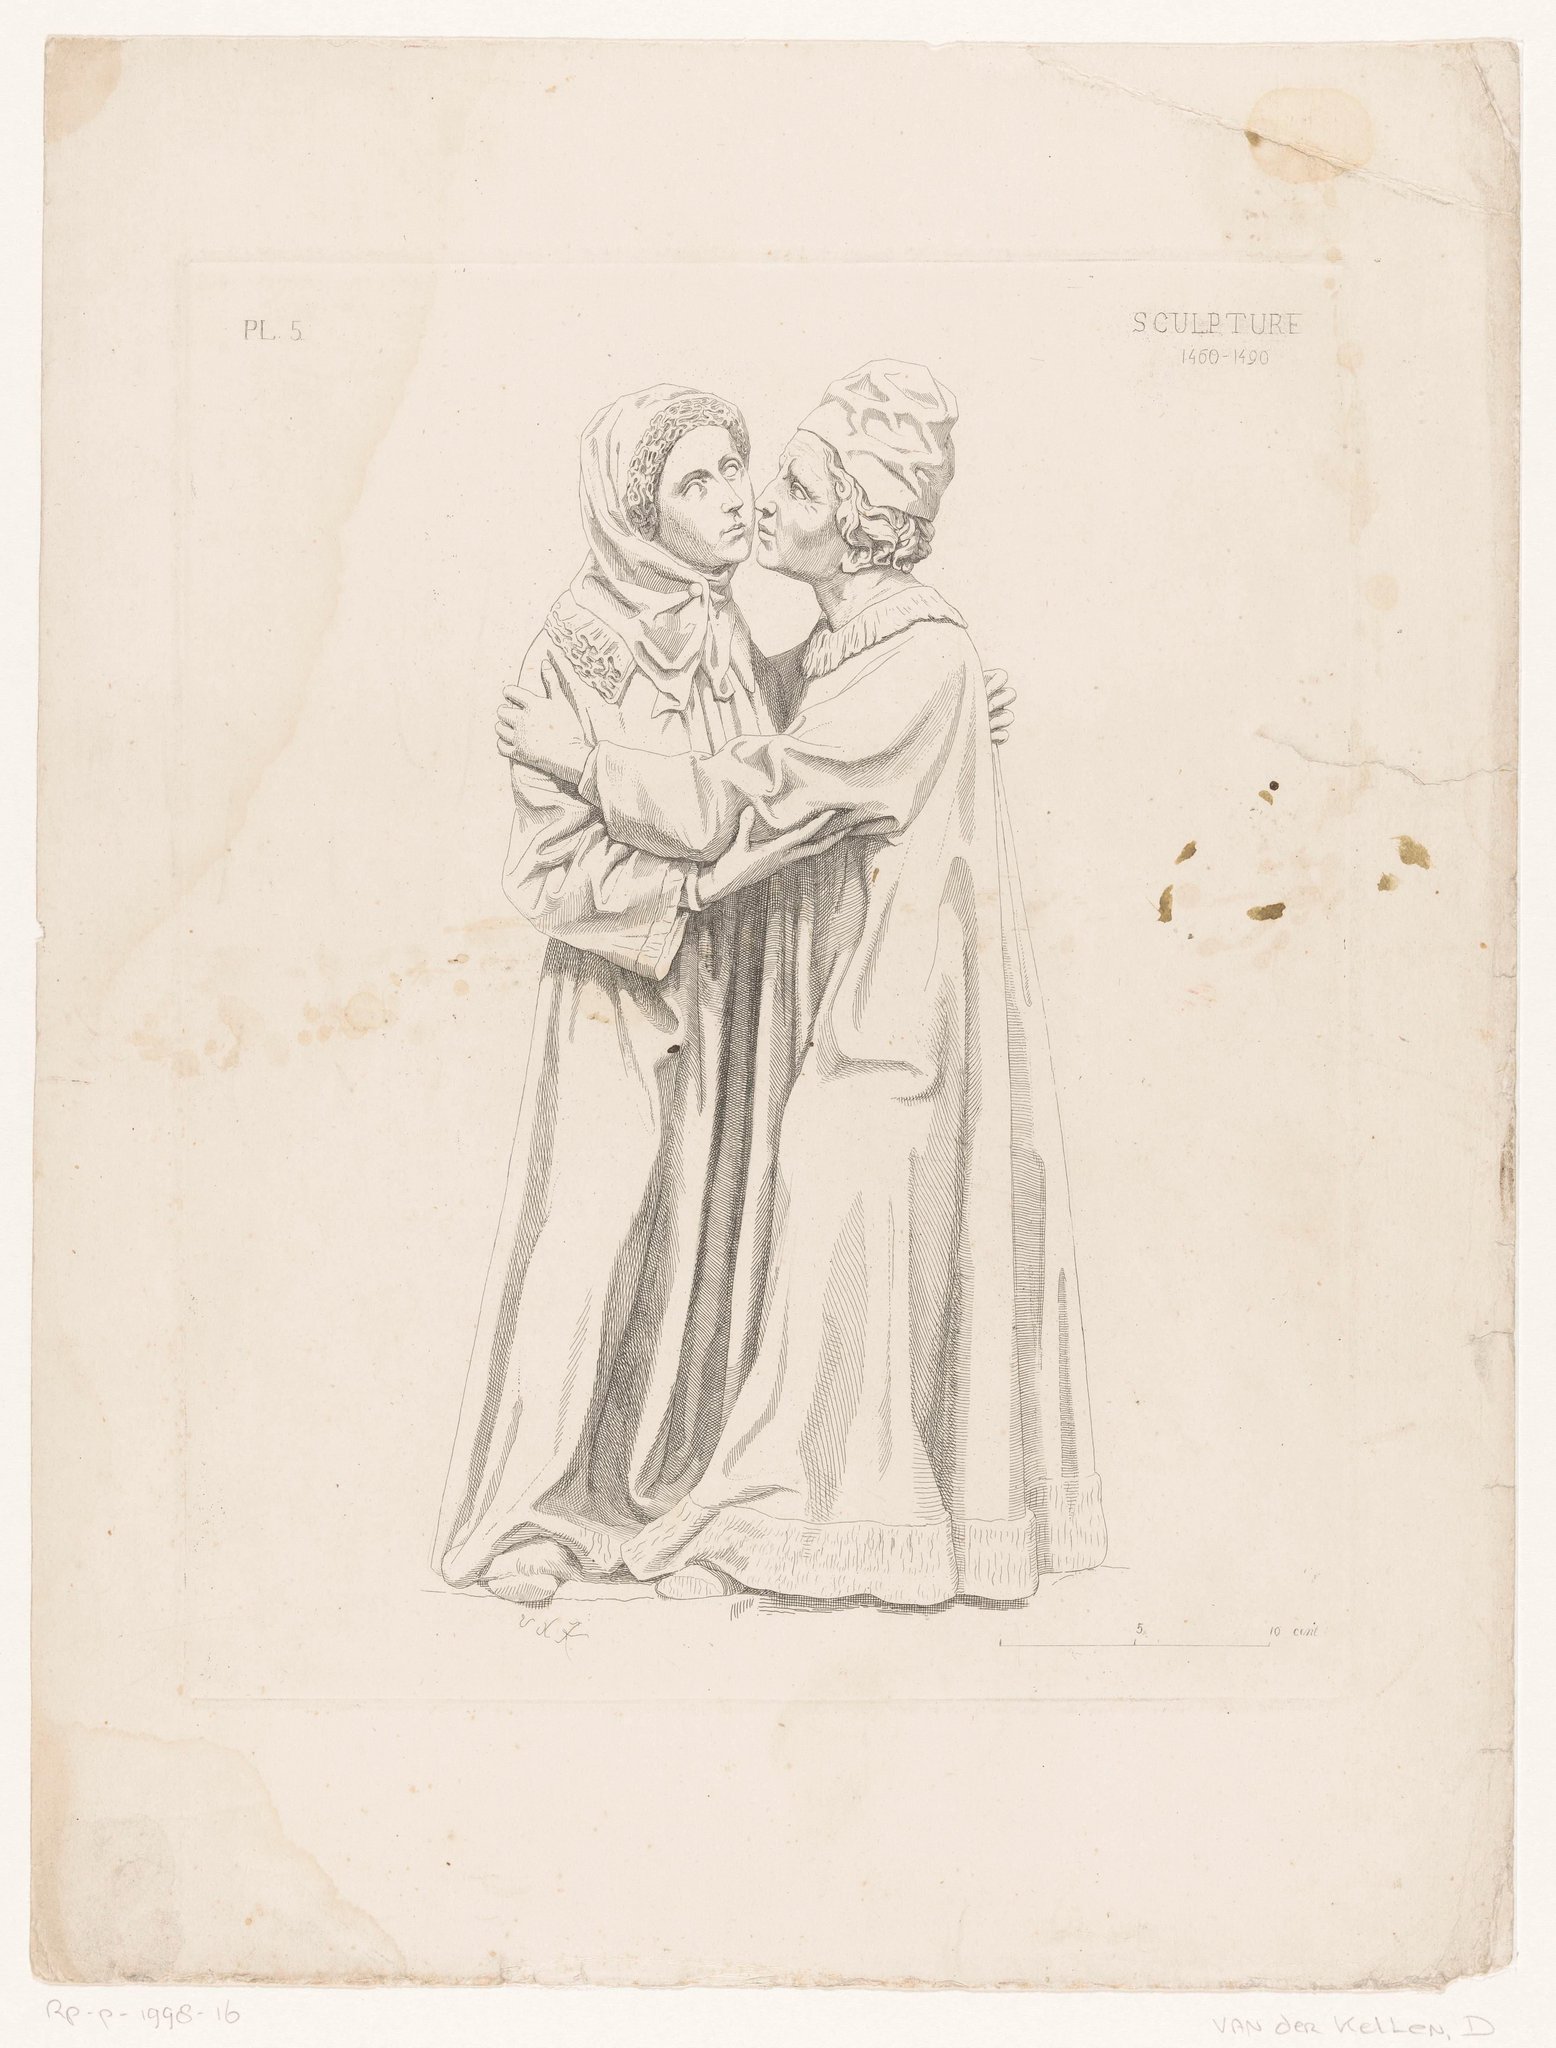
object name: print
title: Ontmoeting Joachim en Anna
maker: david van der kellen (1804-1879)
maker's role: die cutter, draughtsman, print maker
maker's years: 1804-1879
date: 1865-1878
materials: paper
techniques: etching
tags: meeting of anna and joachim at the golden gate; they usually embrace or kiss each other (immaculate conception of mary)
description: Een houten sculptuur van de ontmoeting van Joachim en Anna.